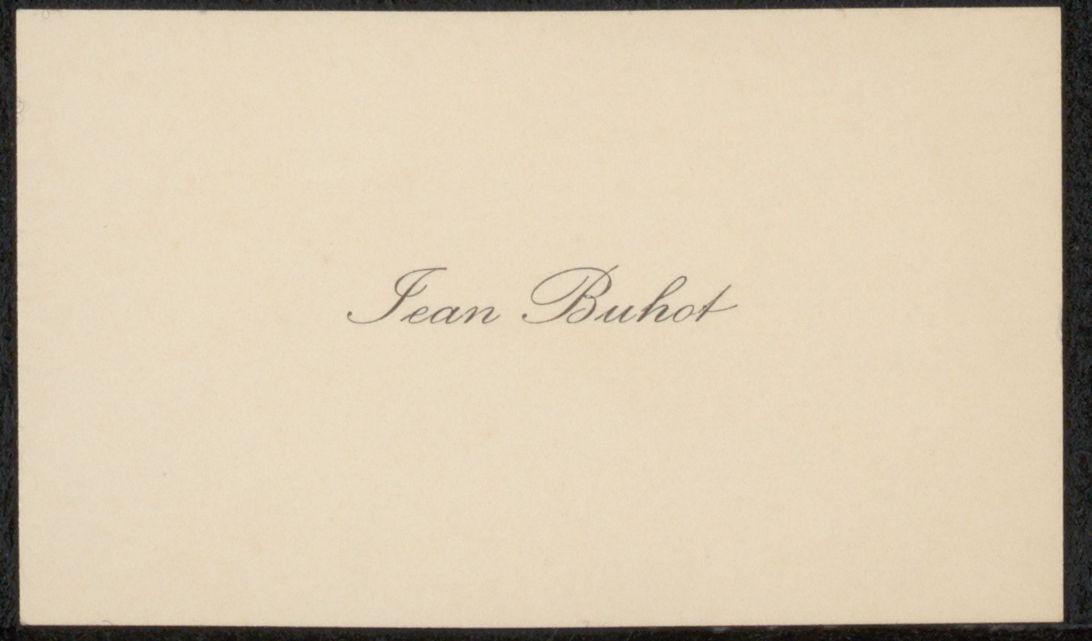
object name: visiting card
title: Visitekaartje aan Philip Zilcken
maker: jean buhot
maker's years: 1885-1952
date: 1895-1952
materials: cardboard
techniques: printing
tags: jean buhot, the hague, painter, draughtsman, philip zilcken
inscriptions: collector's mark: ‘RPK’